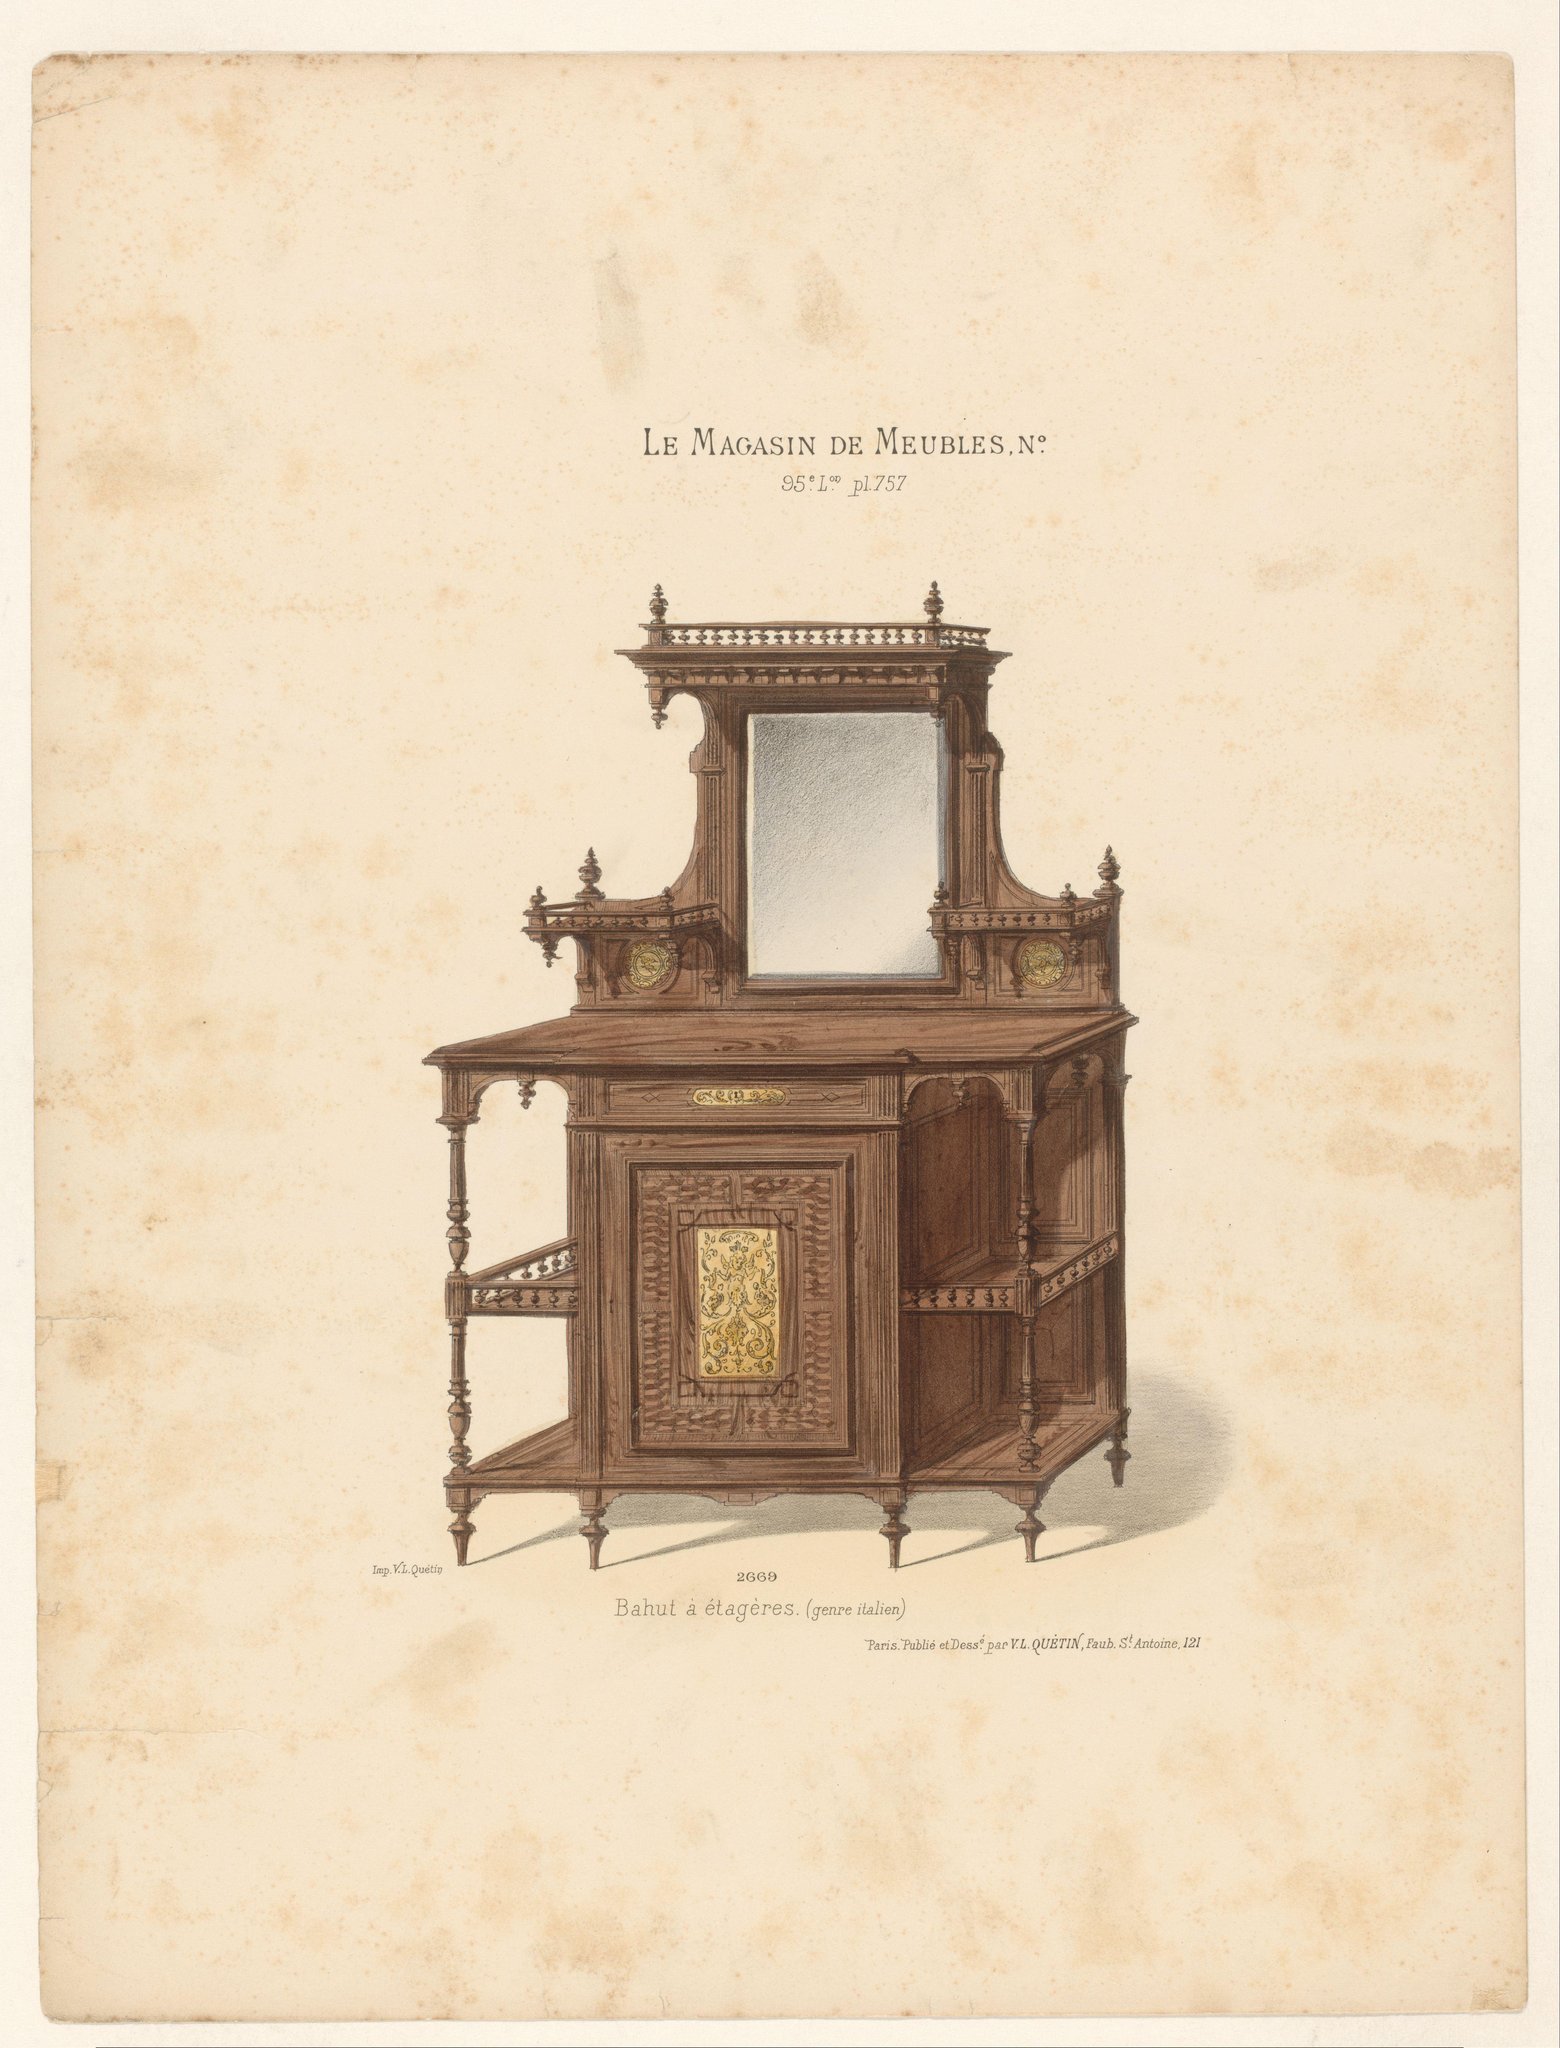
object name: print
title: Kast met spiegel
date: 1878-1904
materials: paper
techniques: hand coloring, lithograph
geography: paris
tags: furniture for storage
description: Een kast met spiegel. Prent uit 95e Livraison.